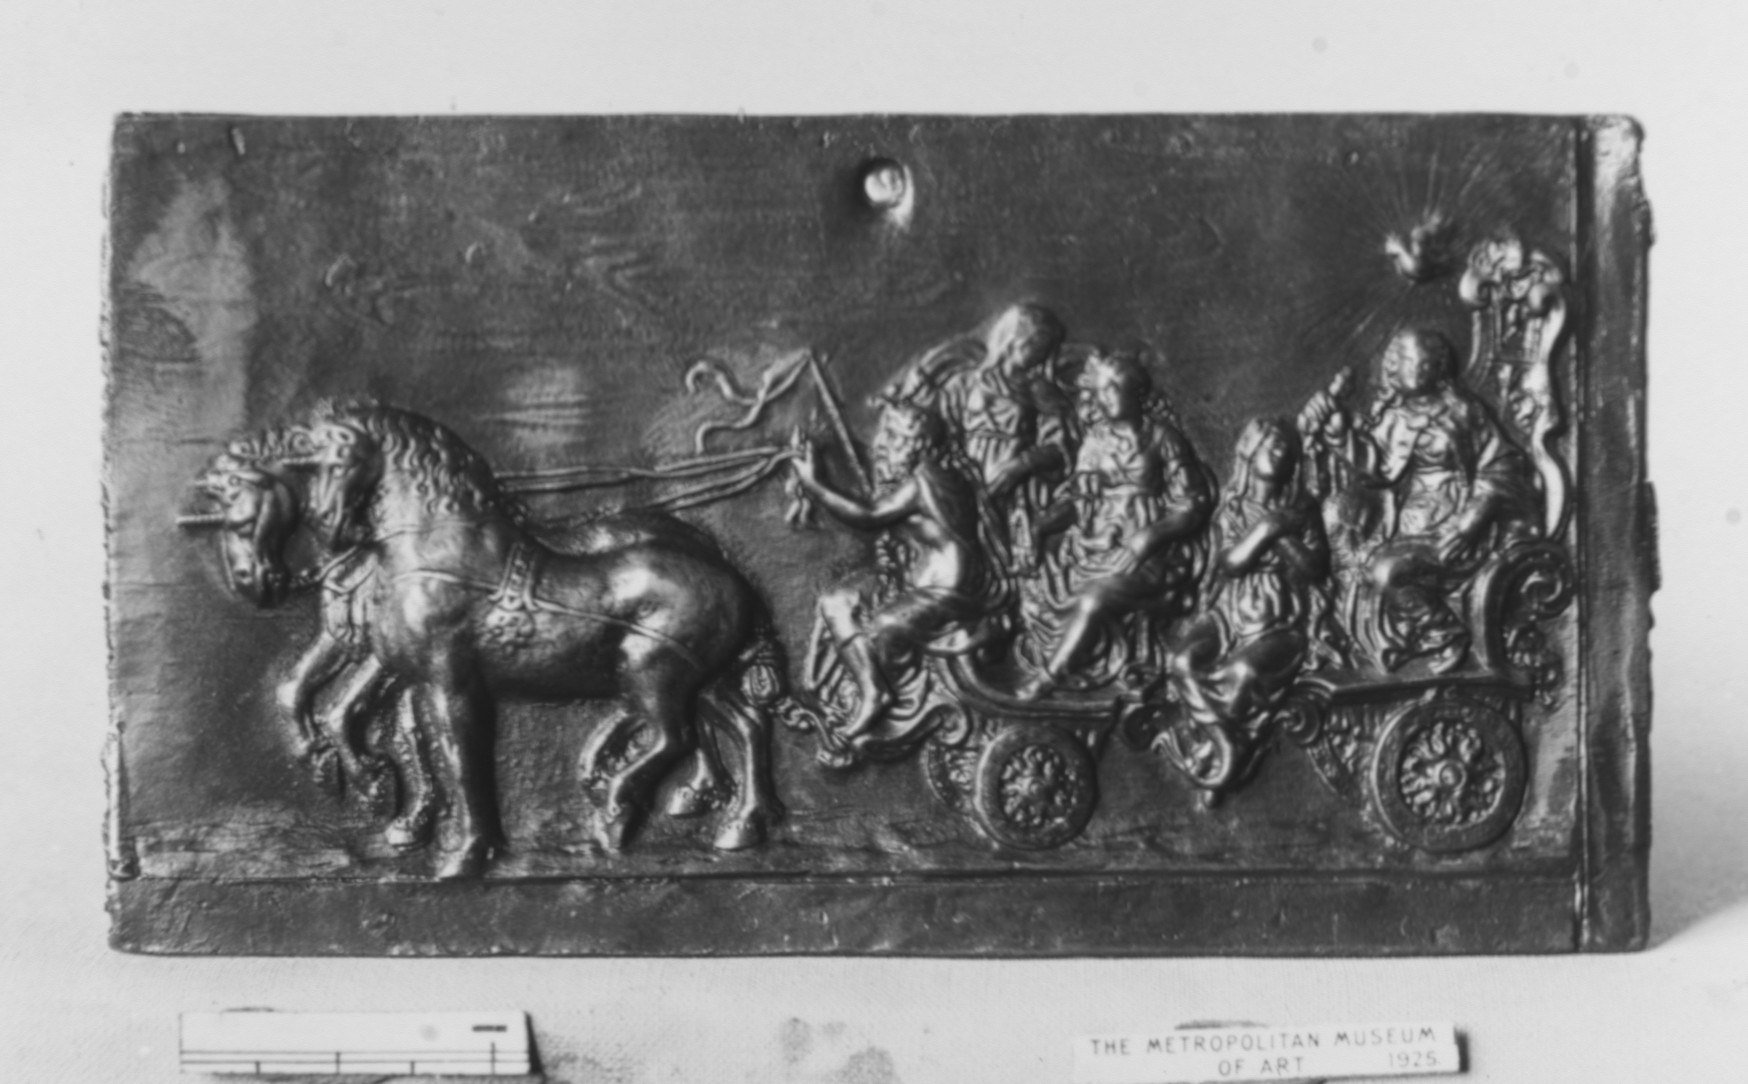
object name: plaquette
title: The Triumph of the Church (one of a series)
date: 1576-1600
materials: bronze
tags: men,horses,carriages